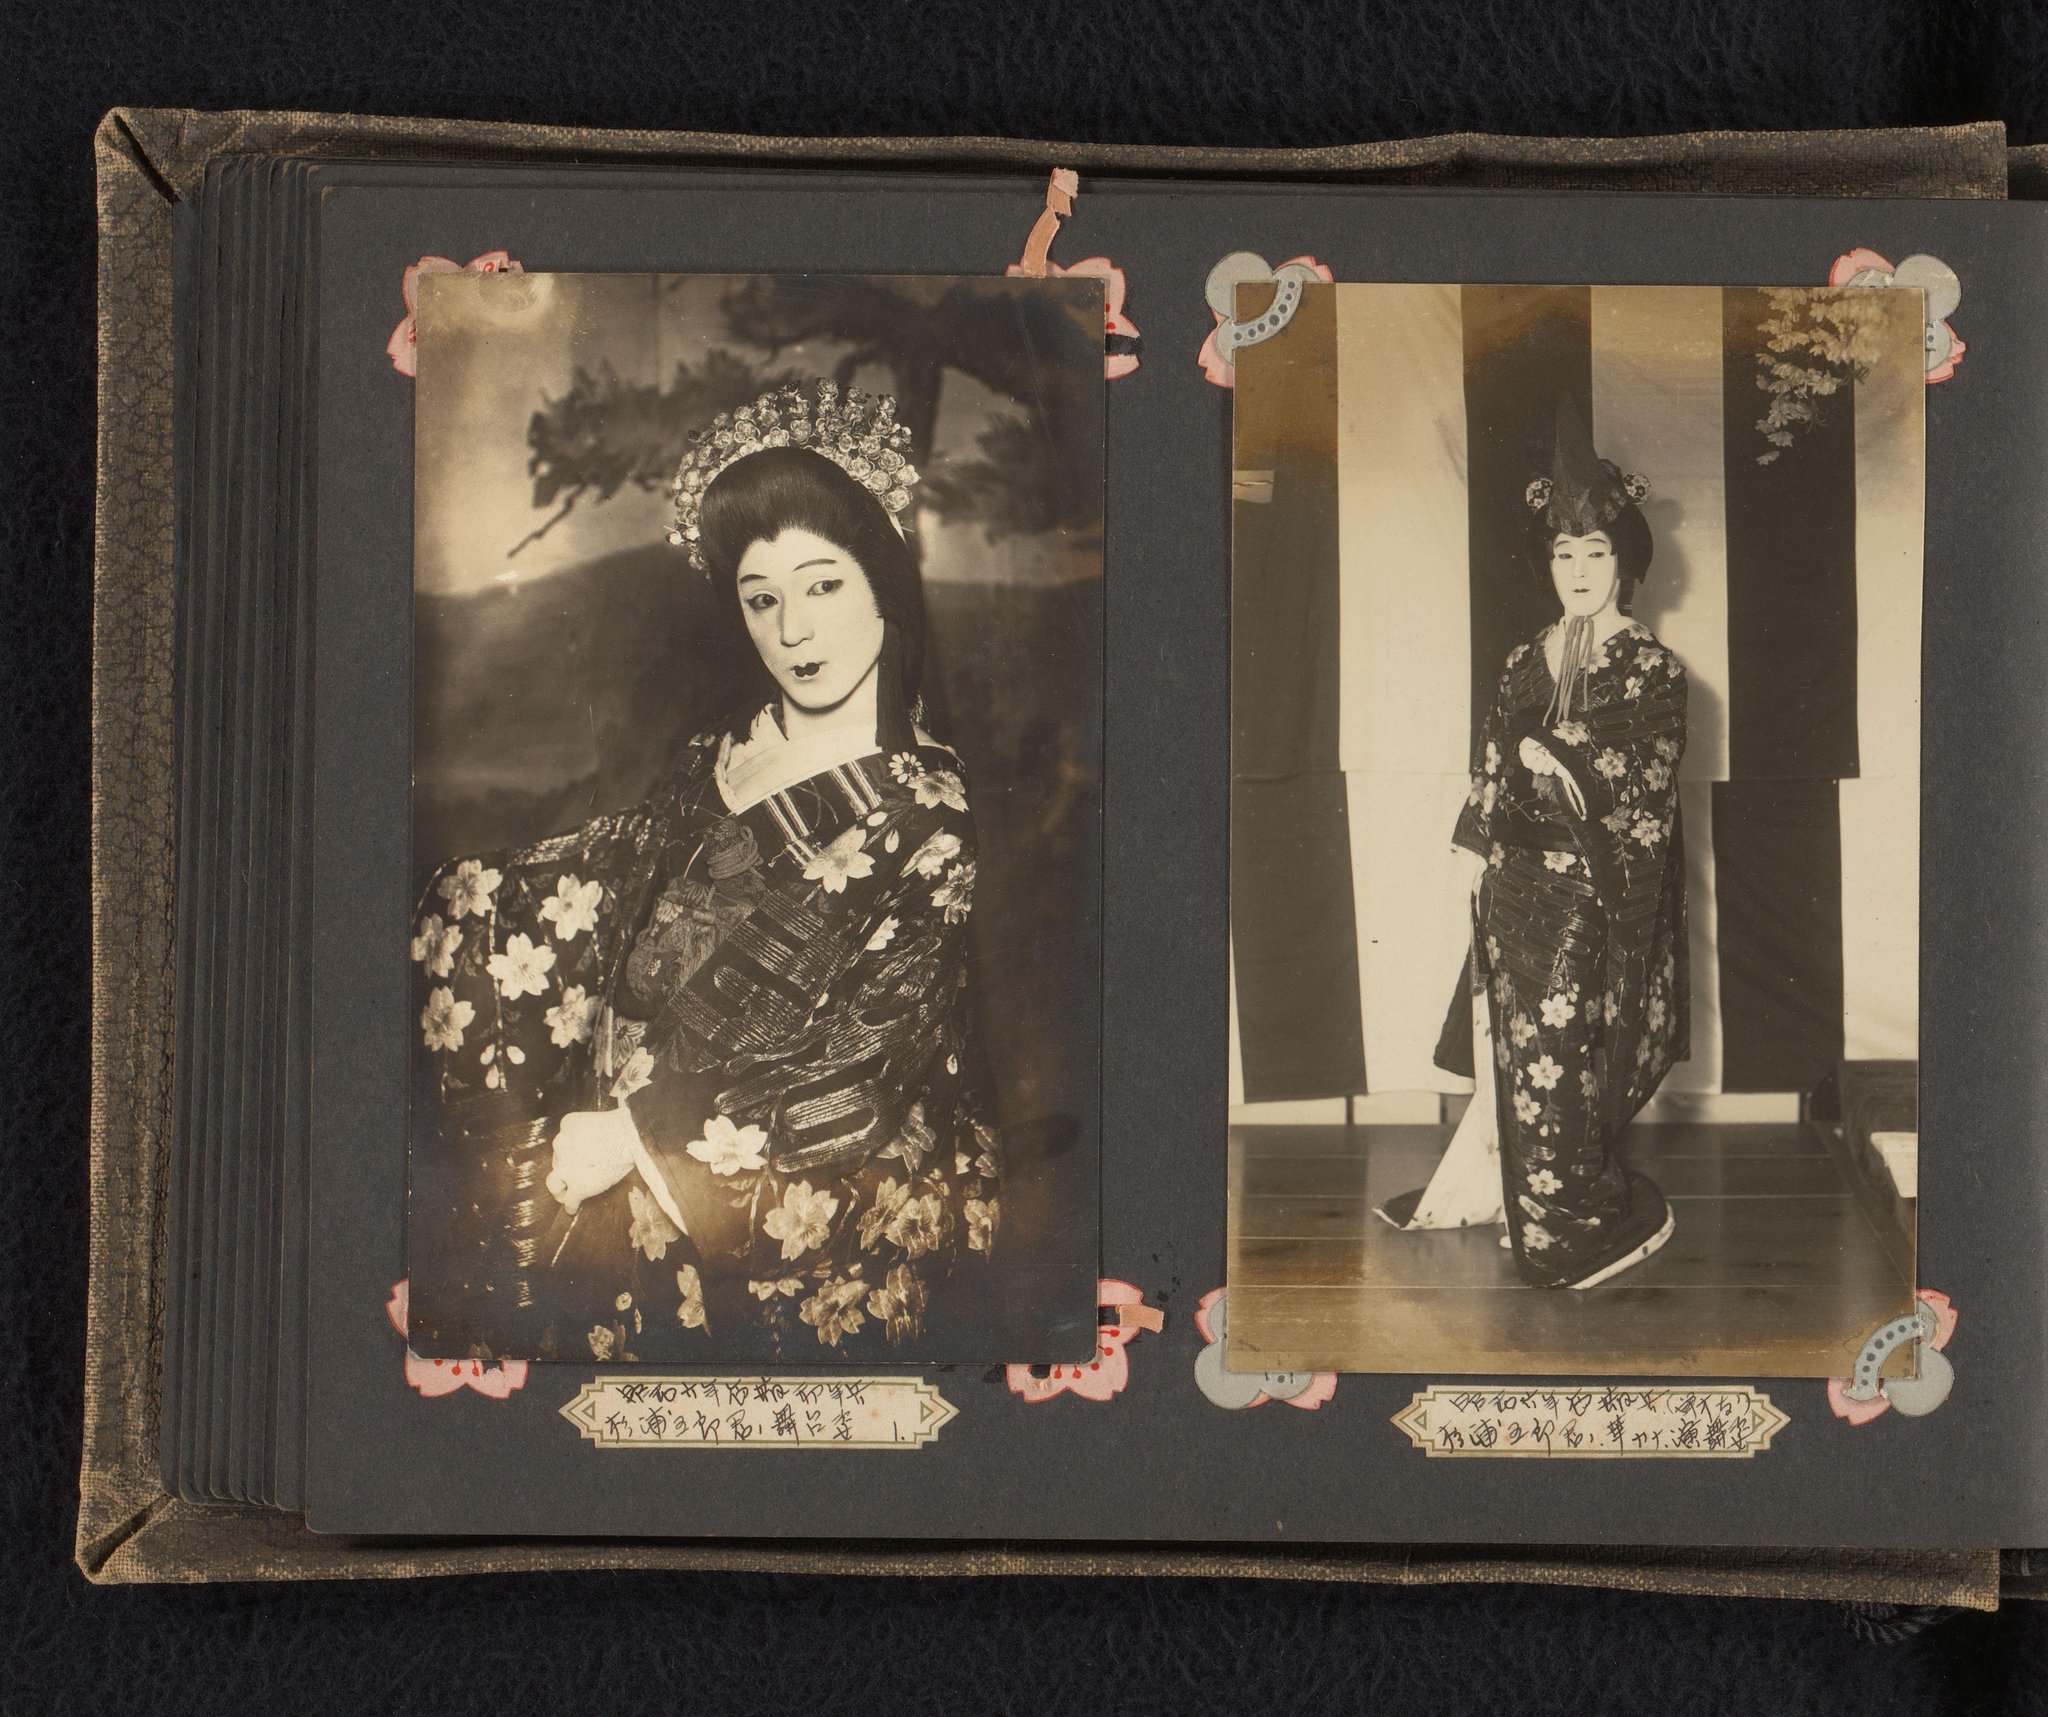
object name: album leaf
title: Japanse acteur tijdens een kabuki voorstelling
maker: Anonymous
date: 1930-1940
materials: paper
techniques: gelatin silver print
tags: theatre, theatrical performance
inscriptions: inscription: ‘[...]’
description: Deze foto's zijn onderdeel van een album.